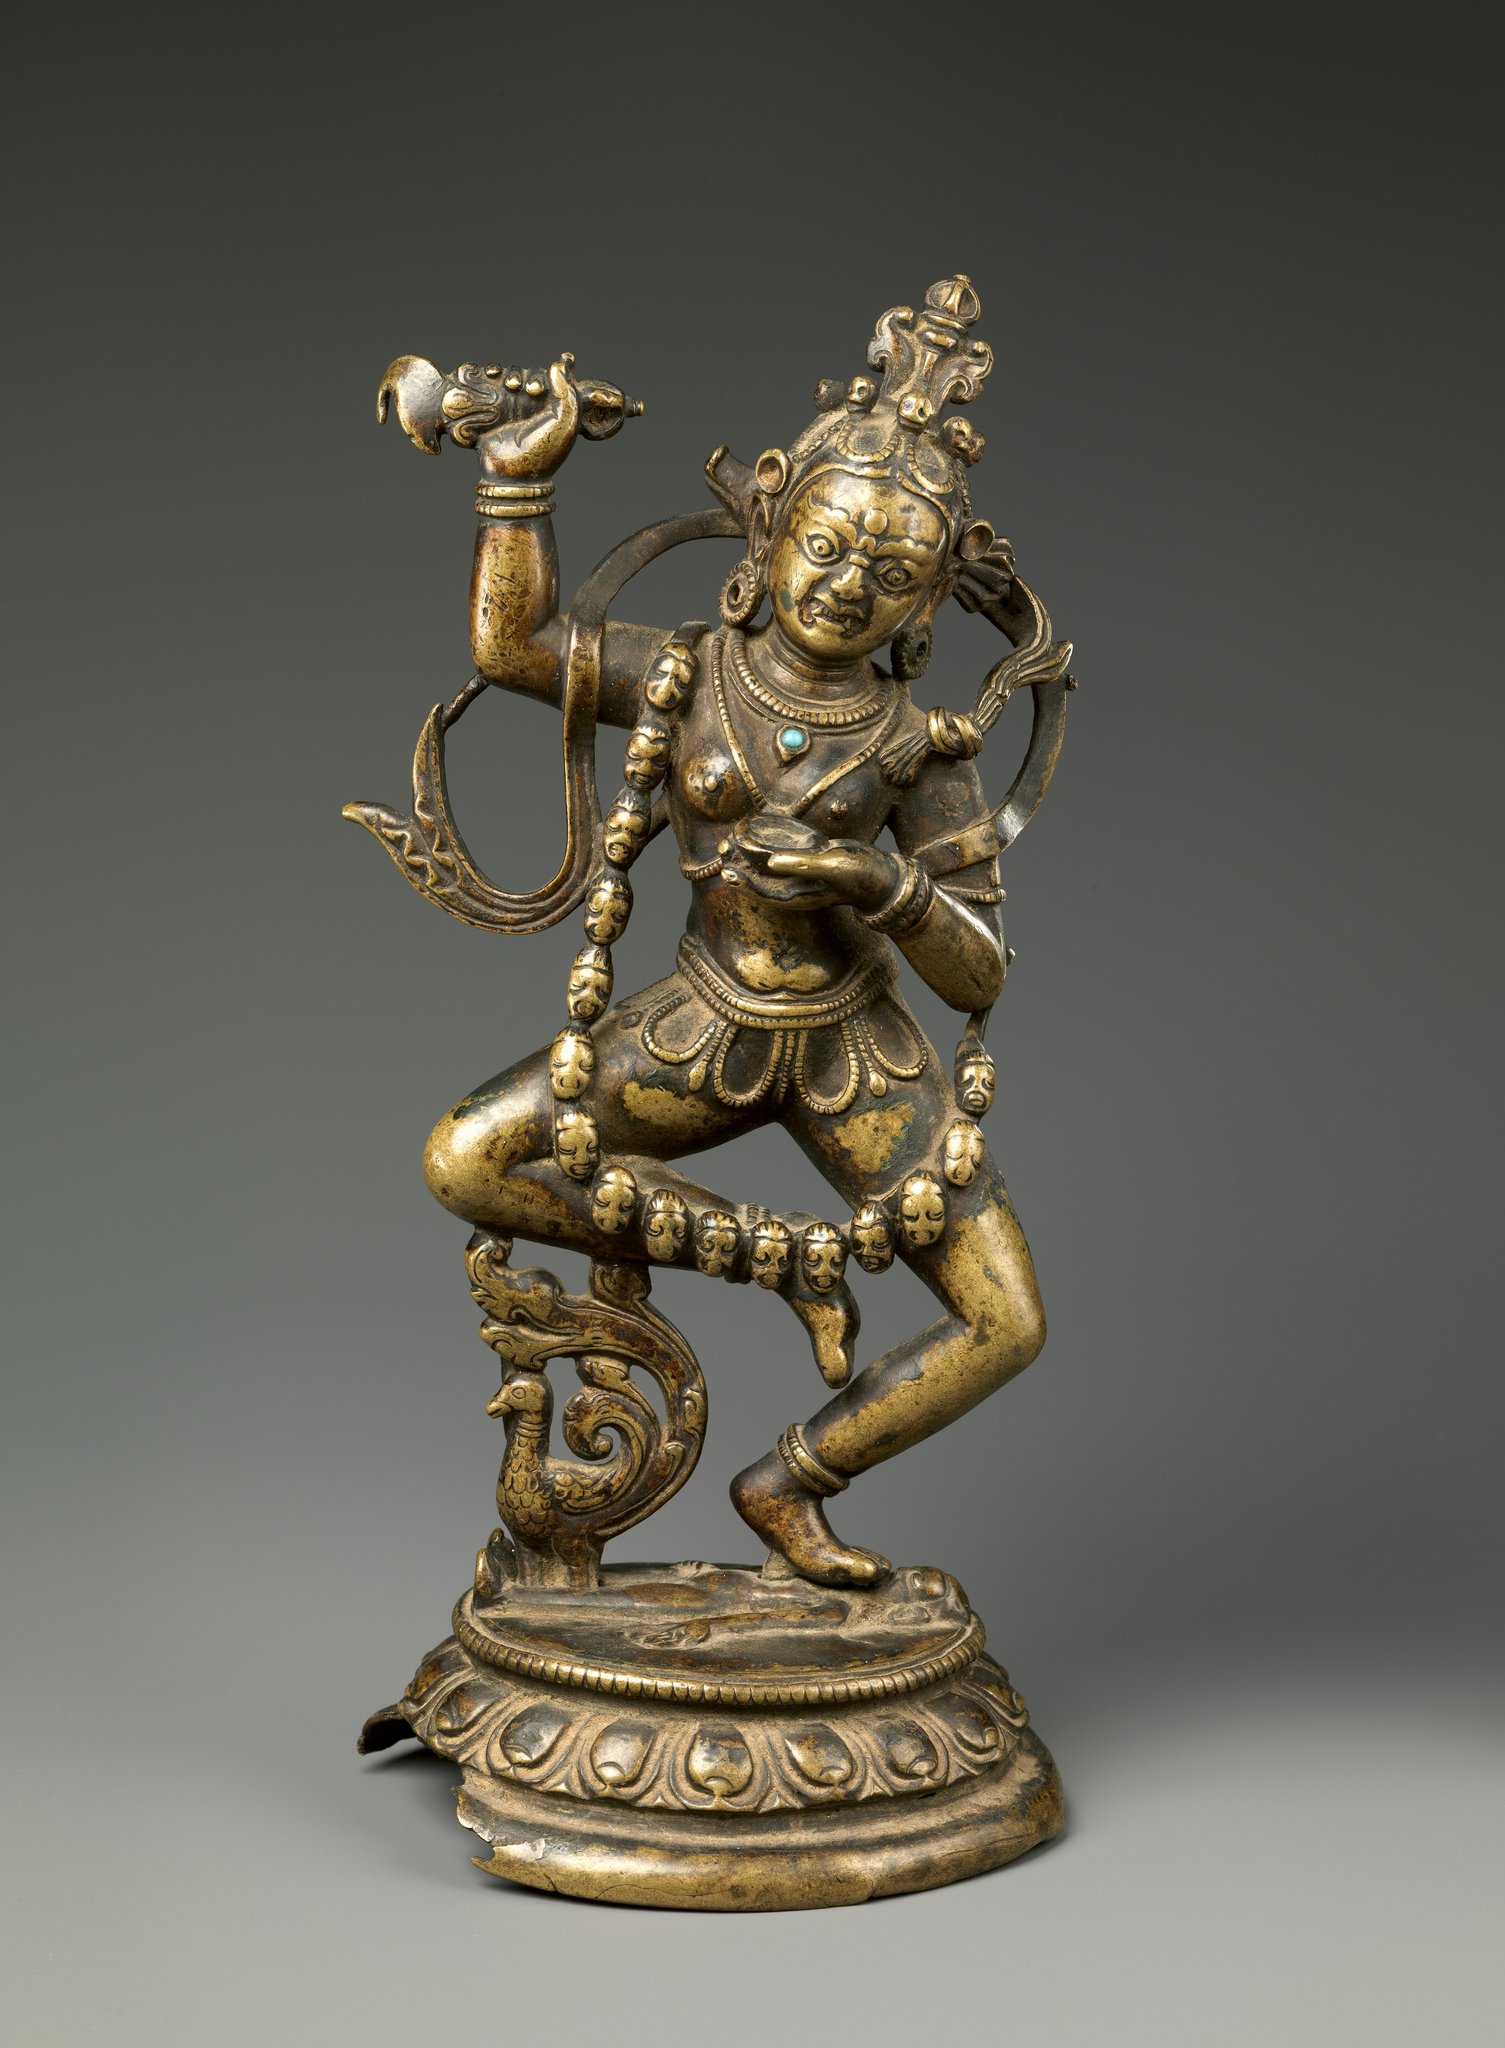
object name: figure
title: Vajravarahi in Wrathful Posture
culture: tibetan, central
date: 1201-1300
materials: copper alloy, silver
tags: dancing,goddess